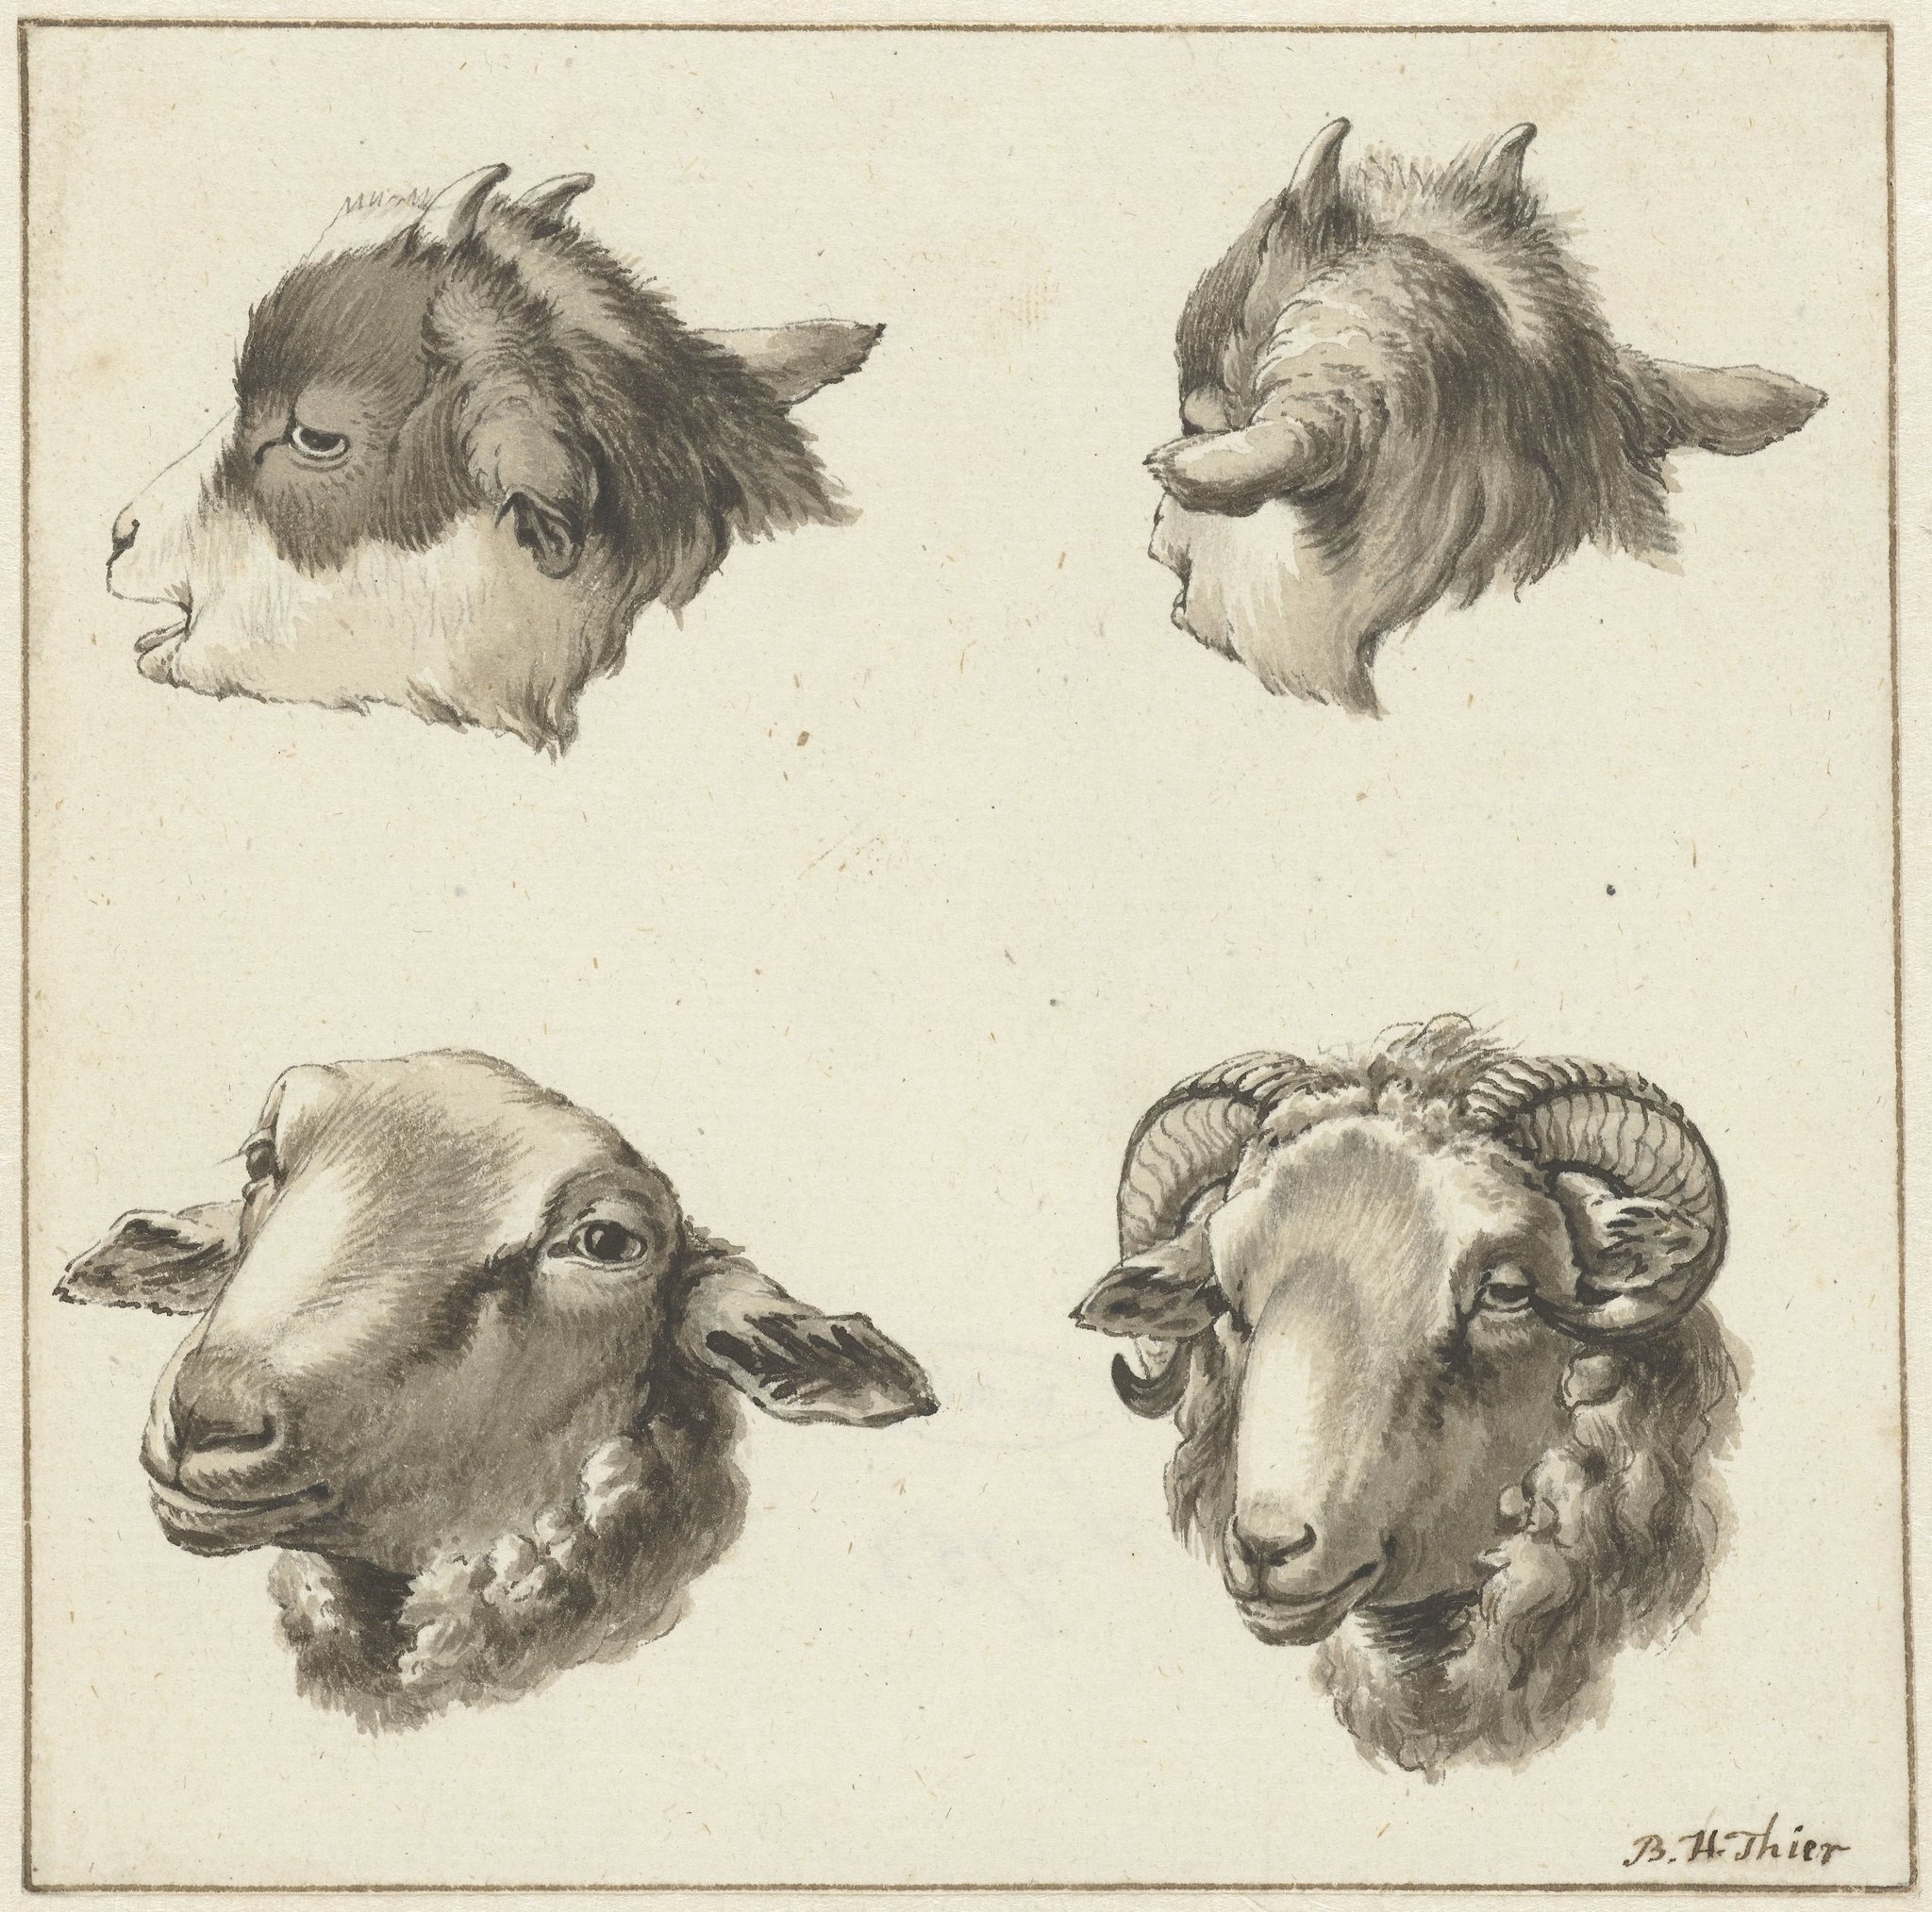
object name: drawing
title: Vier koppen van bokken en schapen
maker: barend hendrik thier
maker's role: draughtsman, print maker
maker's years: 1743-1811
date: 1750-1811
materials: ink, paper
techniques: pen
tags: kid (goat) (+ head of an animal), sheep (+ head of an animal)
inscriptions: signature: ‘B.H. Thier’